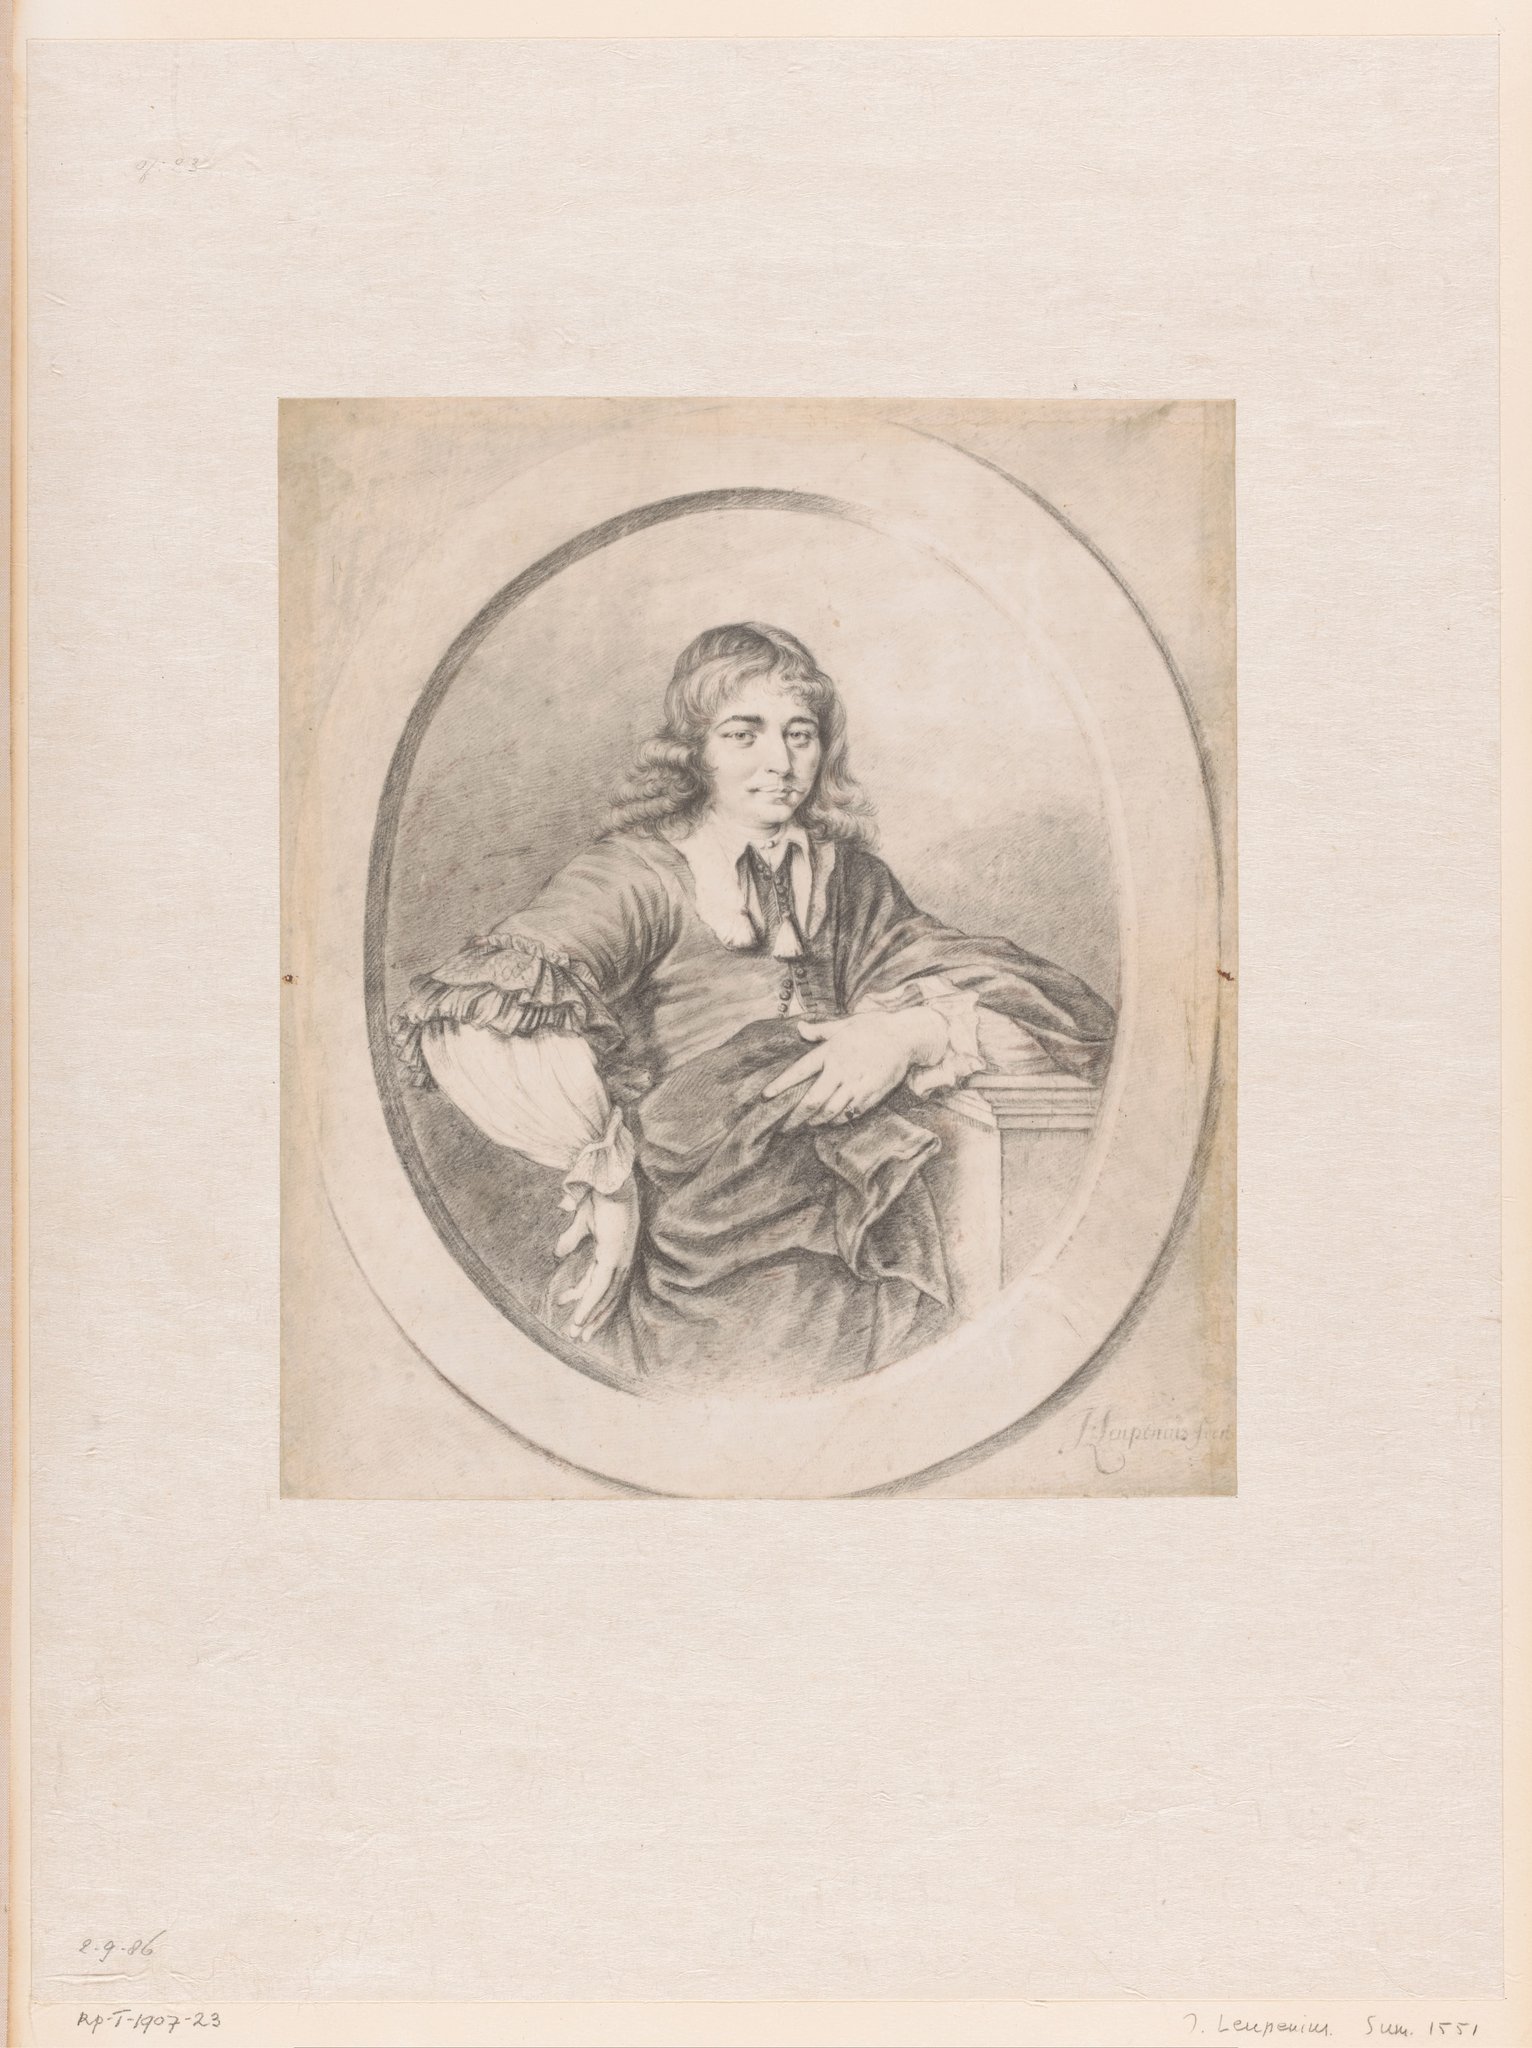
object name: drawing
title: Portrait of a Young Man Leaning on a Pilaster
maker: johannes leupenius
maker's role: draughtsman, painter, print maker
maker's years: 1646-1693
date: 1665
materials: chalk, parchment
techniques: brush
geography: amsterdam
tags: anonymous historical person portrayed alone (+ three-quarter length portrait)